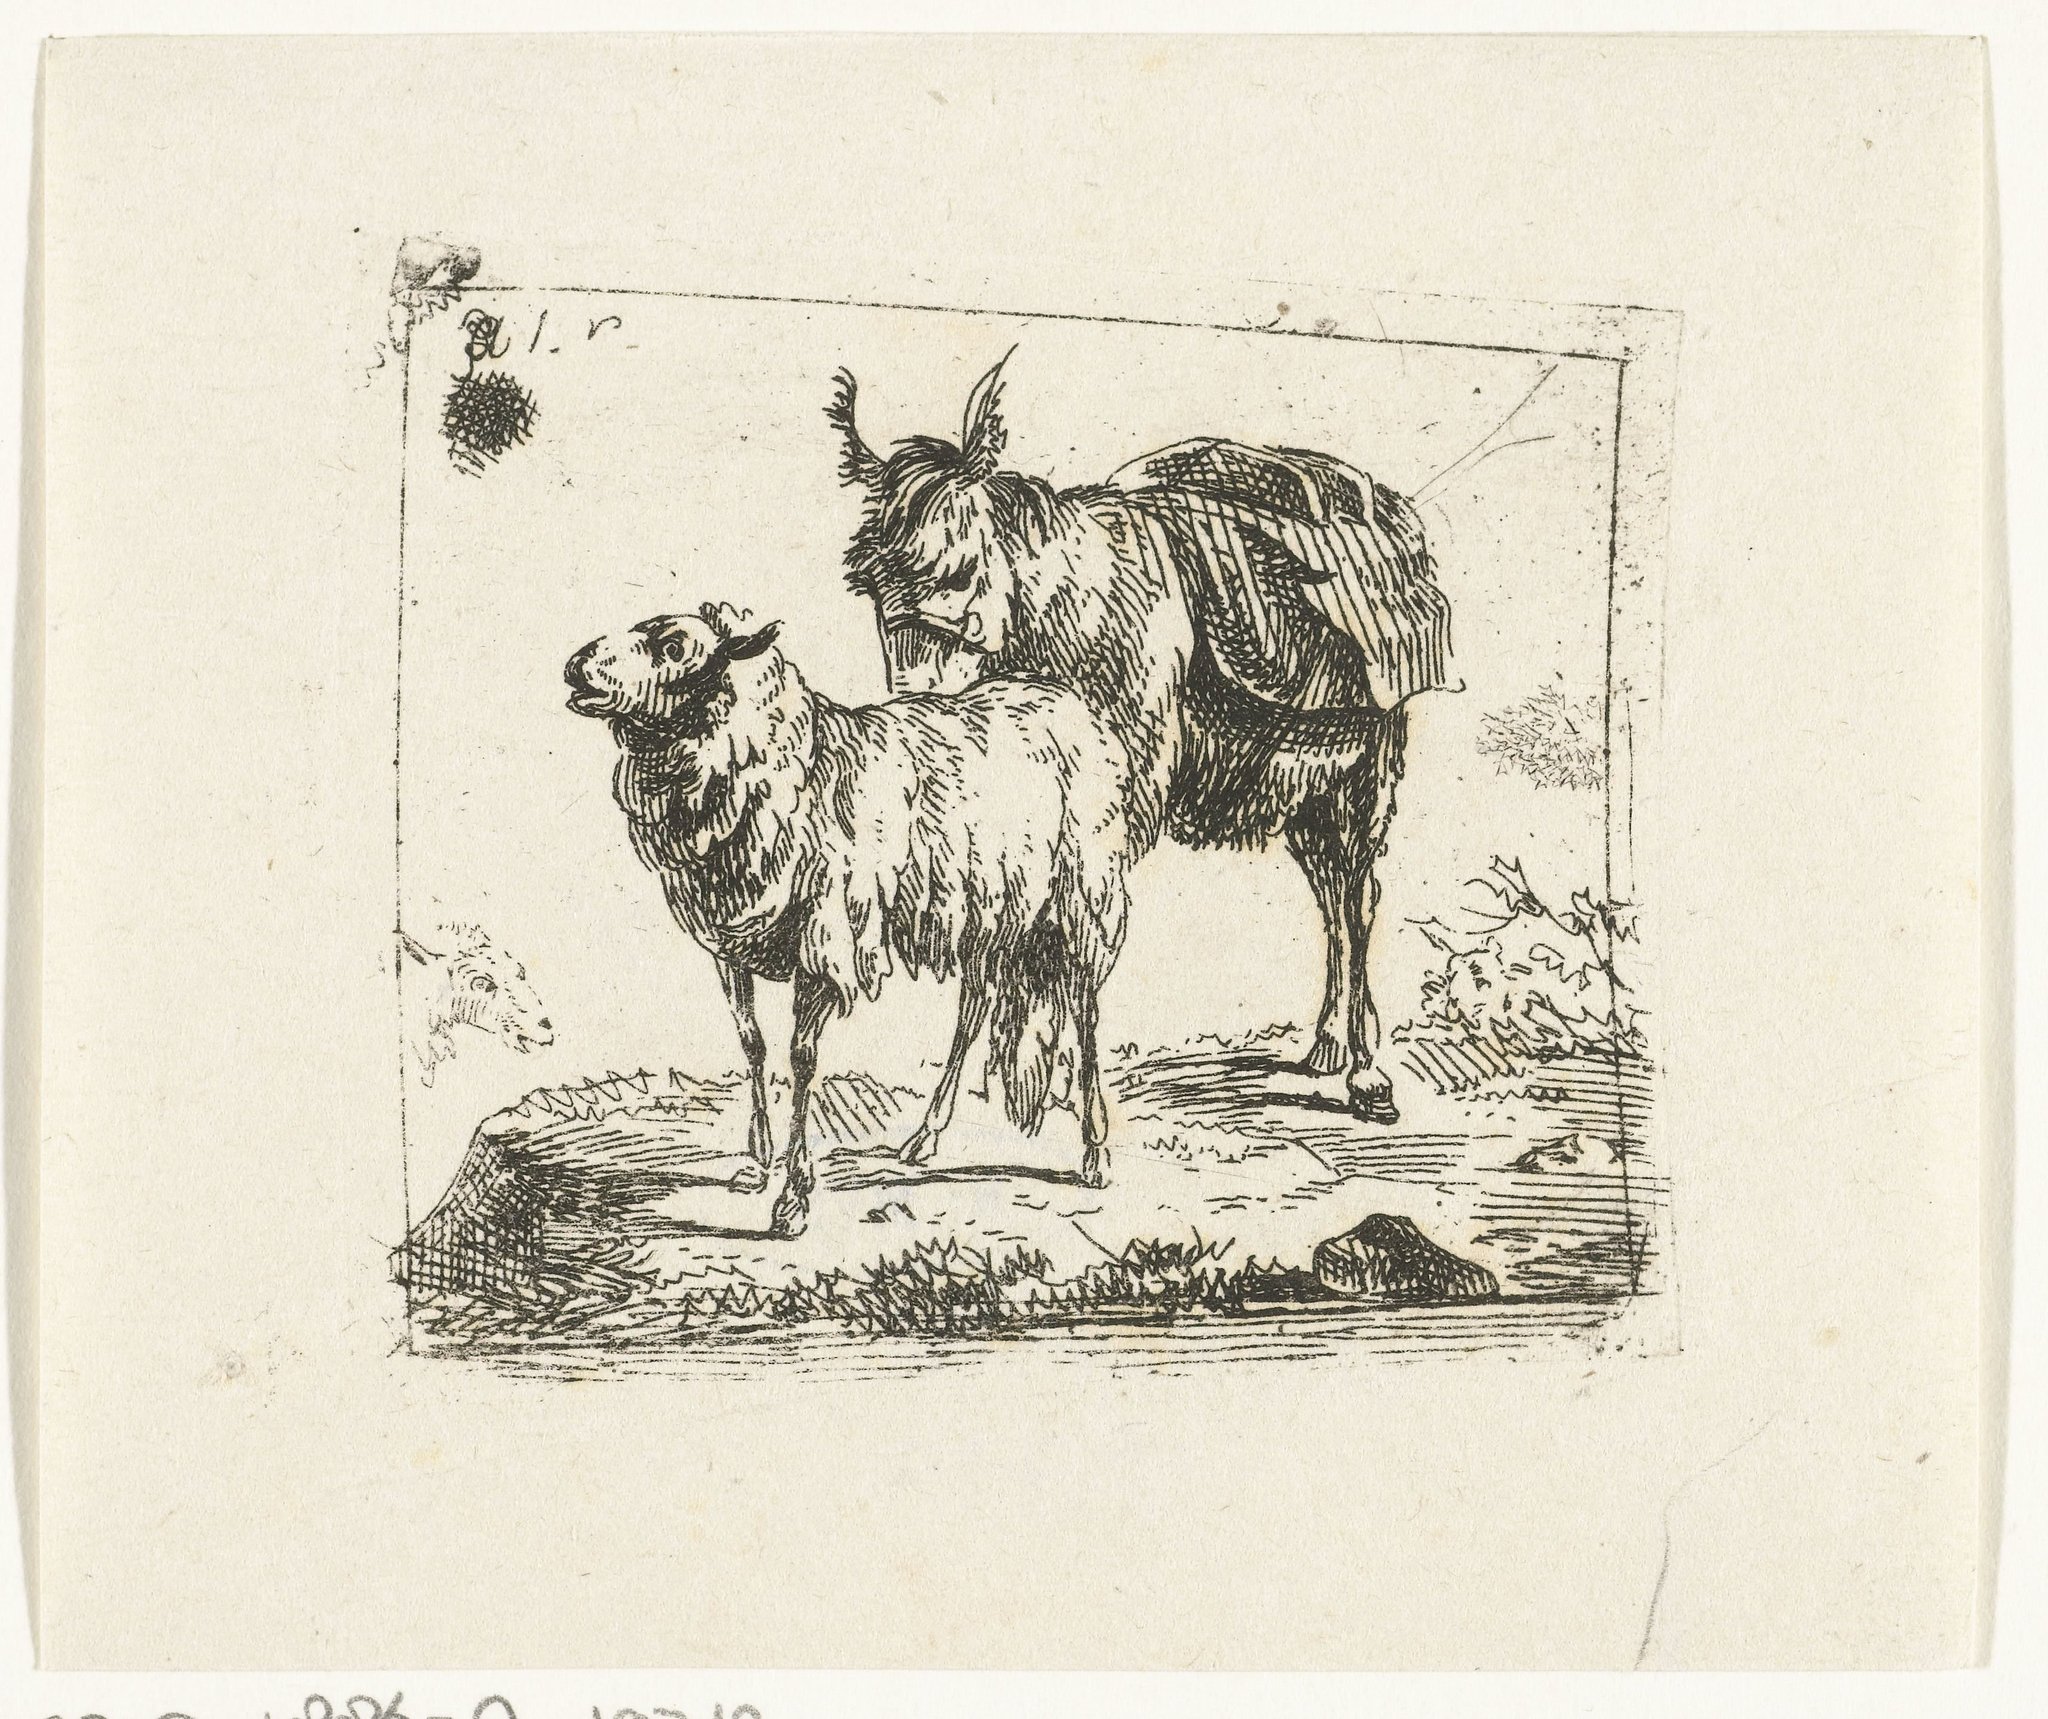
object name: print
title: Staande ezel en schaap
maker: frédéric théodore faber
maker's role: print maker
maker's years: 1782-1844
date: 1805-1806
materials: paper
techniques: etching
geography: brussels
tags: ass, donkey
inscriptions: collector's mark: Lugt 2228